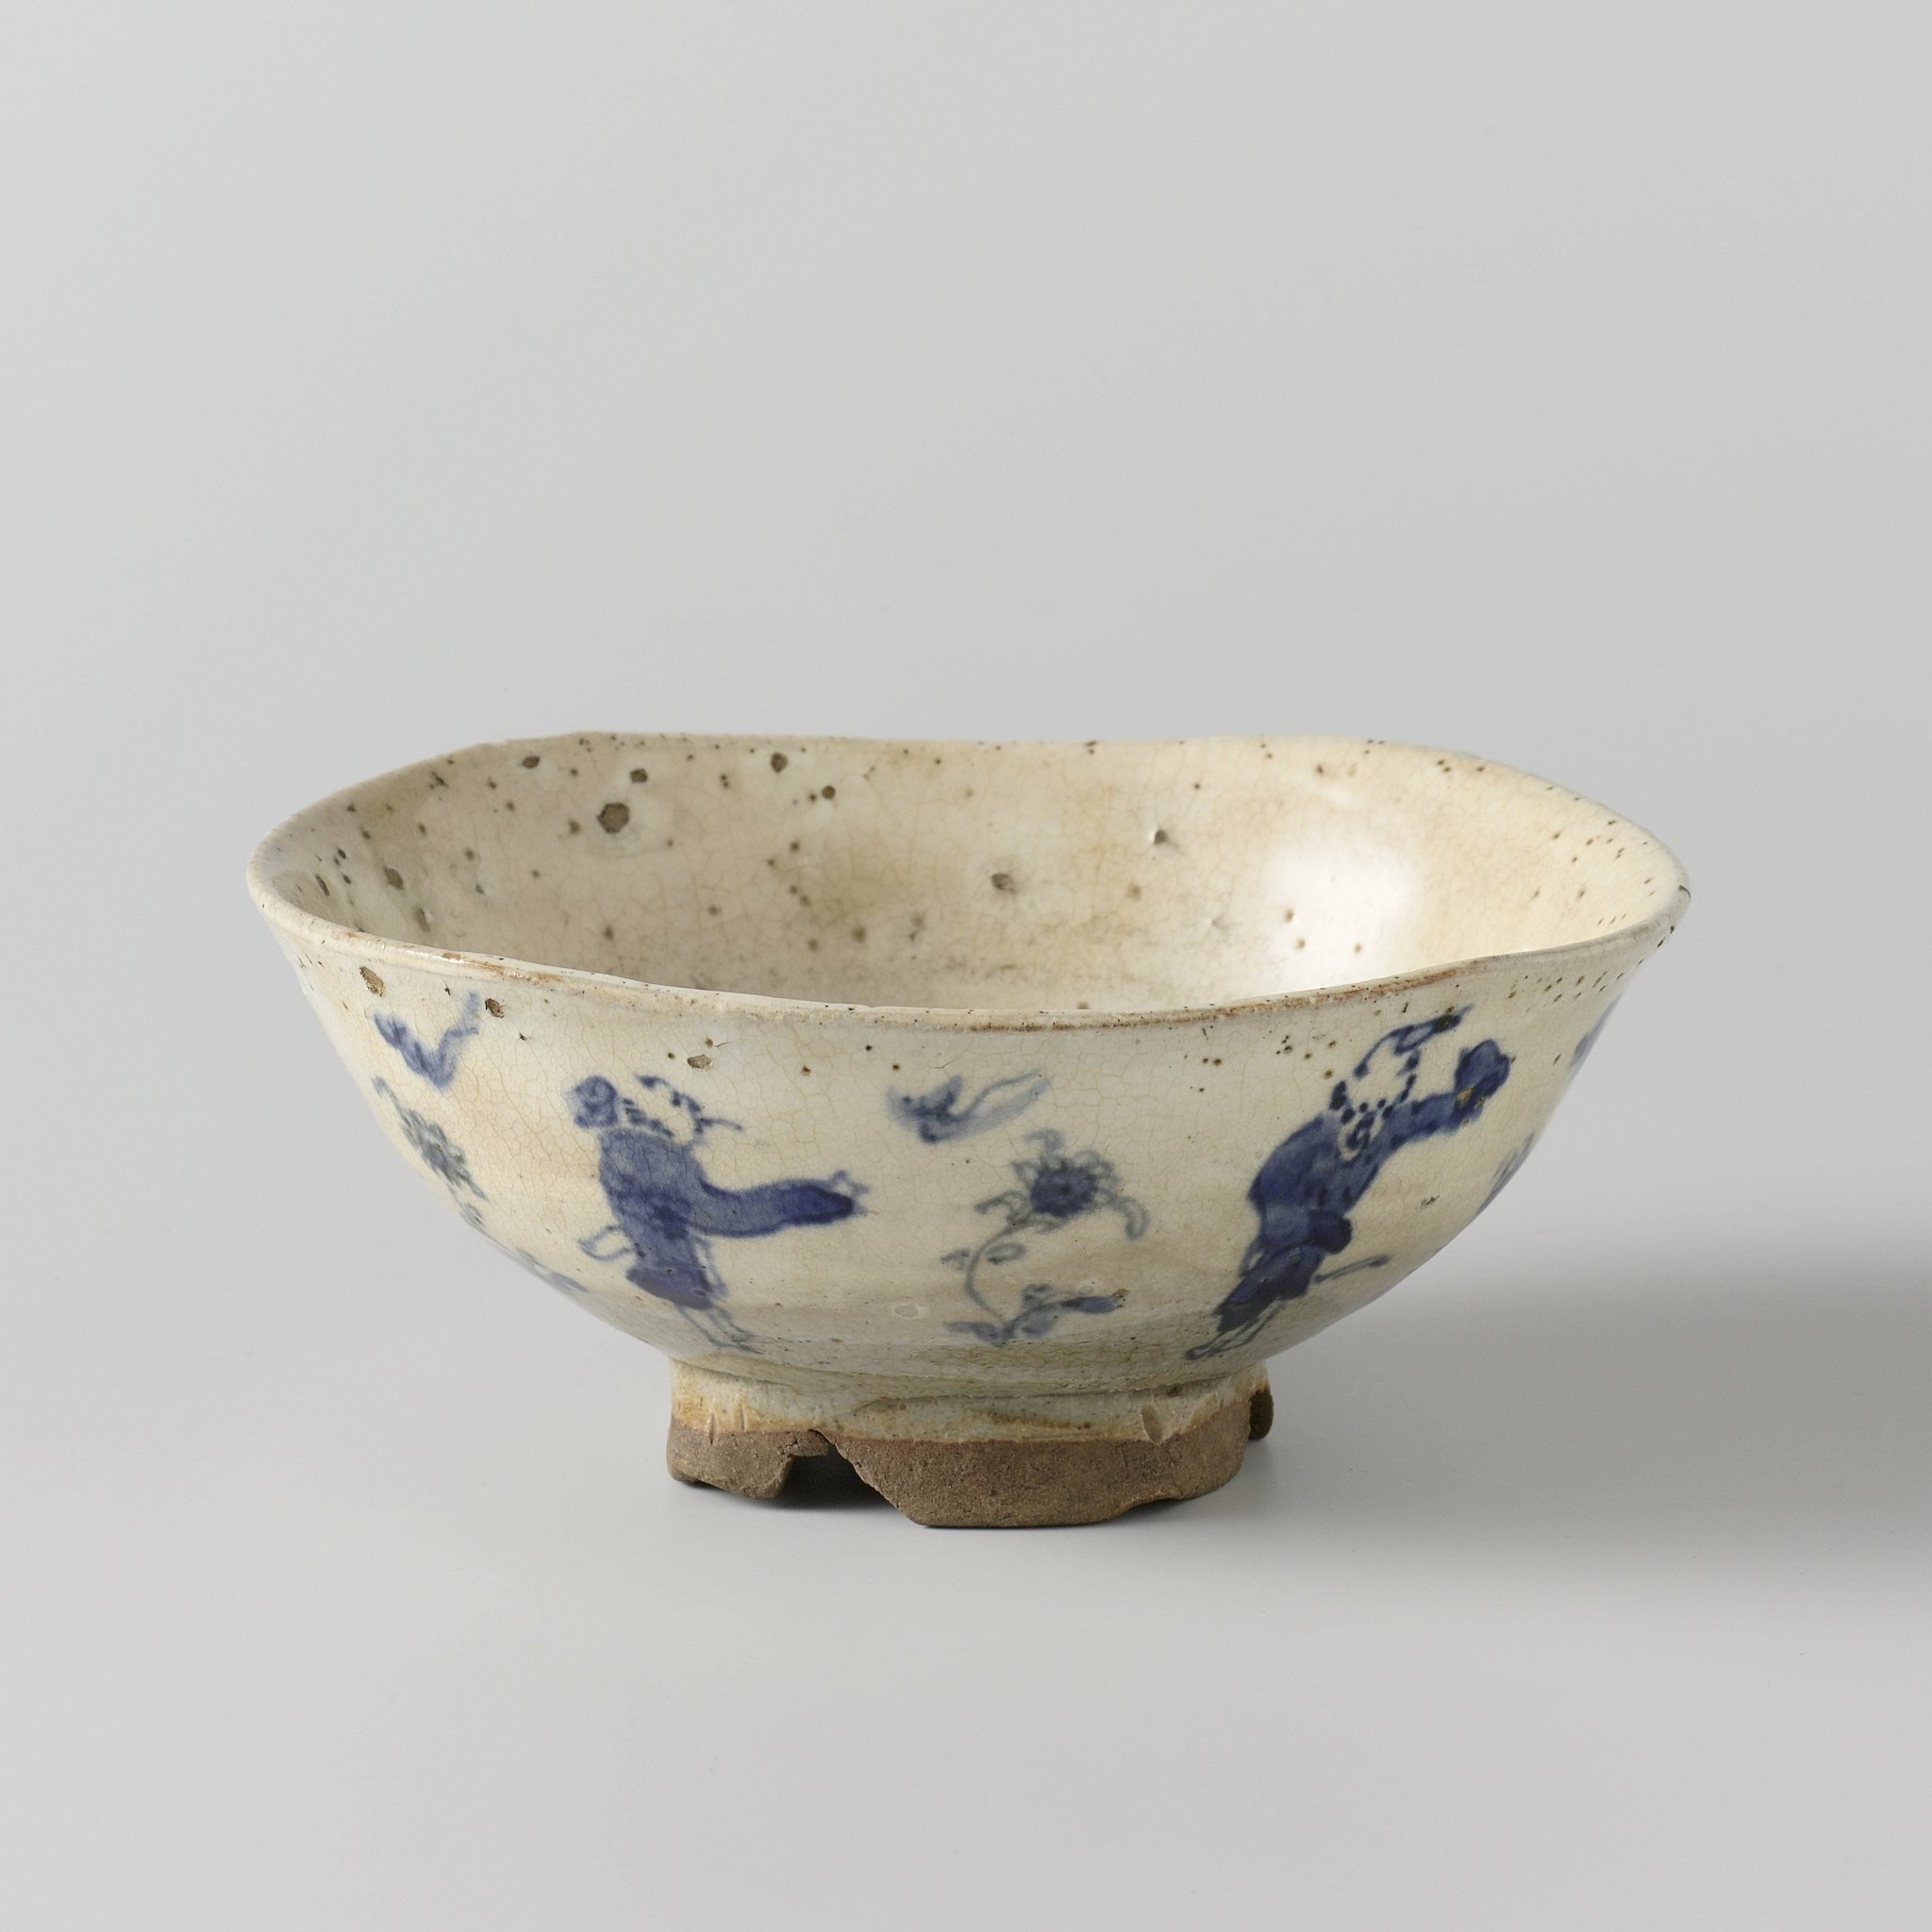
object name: tea bowl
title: Tea bowl with figures and flower sprays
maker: Anonymous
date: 1775-1824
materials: cobalt, glaze, paint, stoneware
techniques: firing, turning, vitrification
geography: japan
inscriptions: label: ‘W679’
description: Theekom van steengoed, gedeeltelijk bedekt met een wit slib en hierop beschilderd in onderglazuur blauw. Op de buitenwand afwisselend vijfmaal een staand persoon, een bloemtak en zes wolken. De voetring is ongeglazuurd. Drie inkepingen in de voetring. Oud label op de onderzijde met 'W679'.